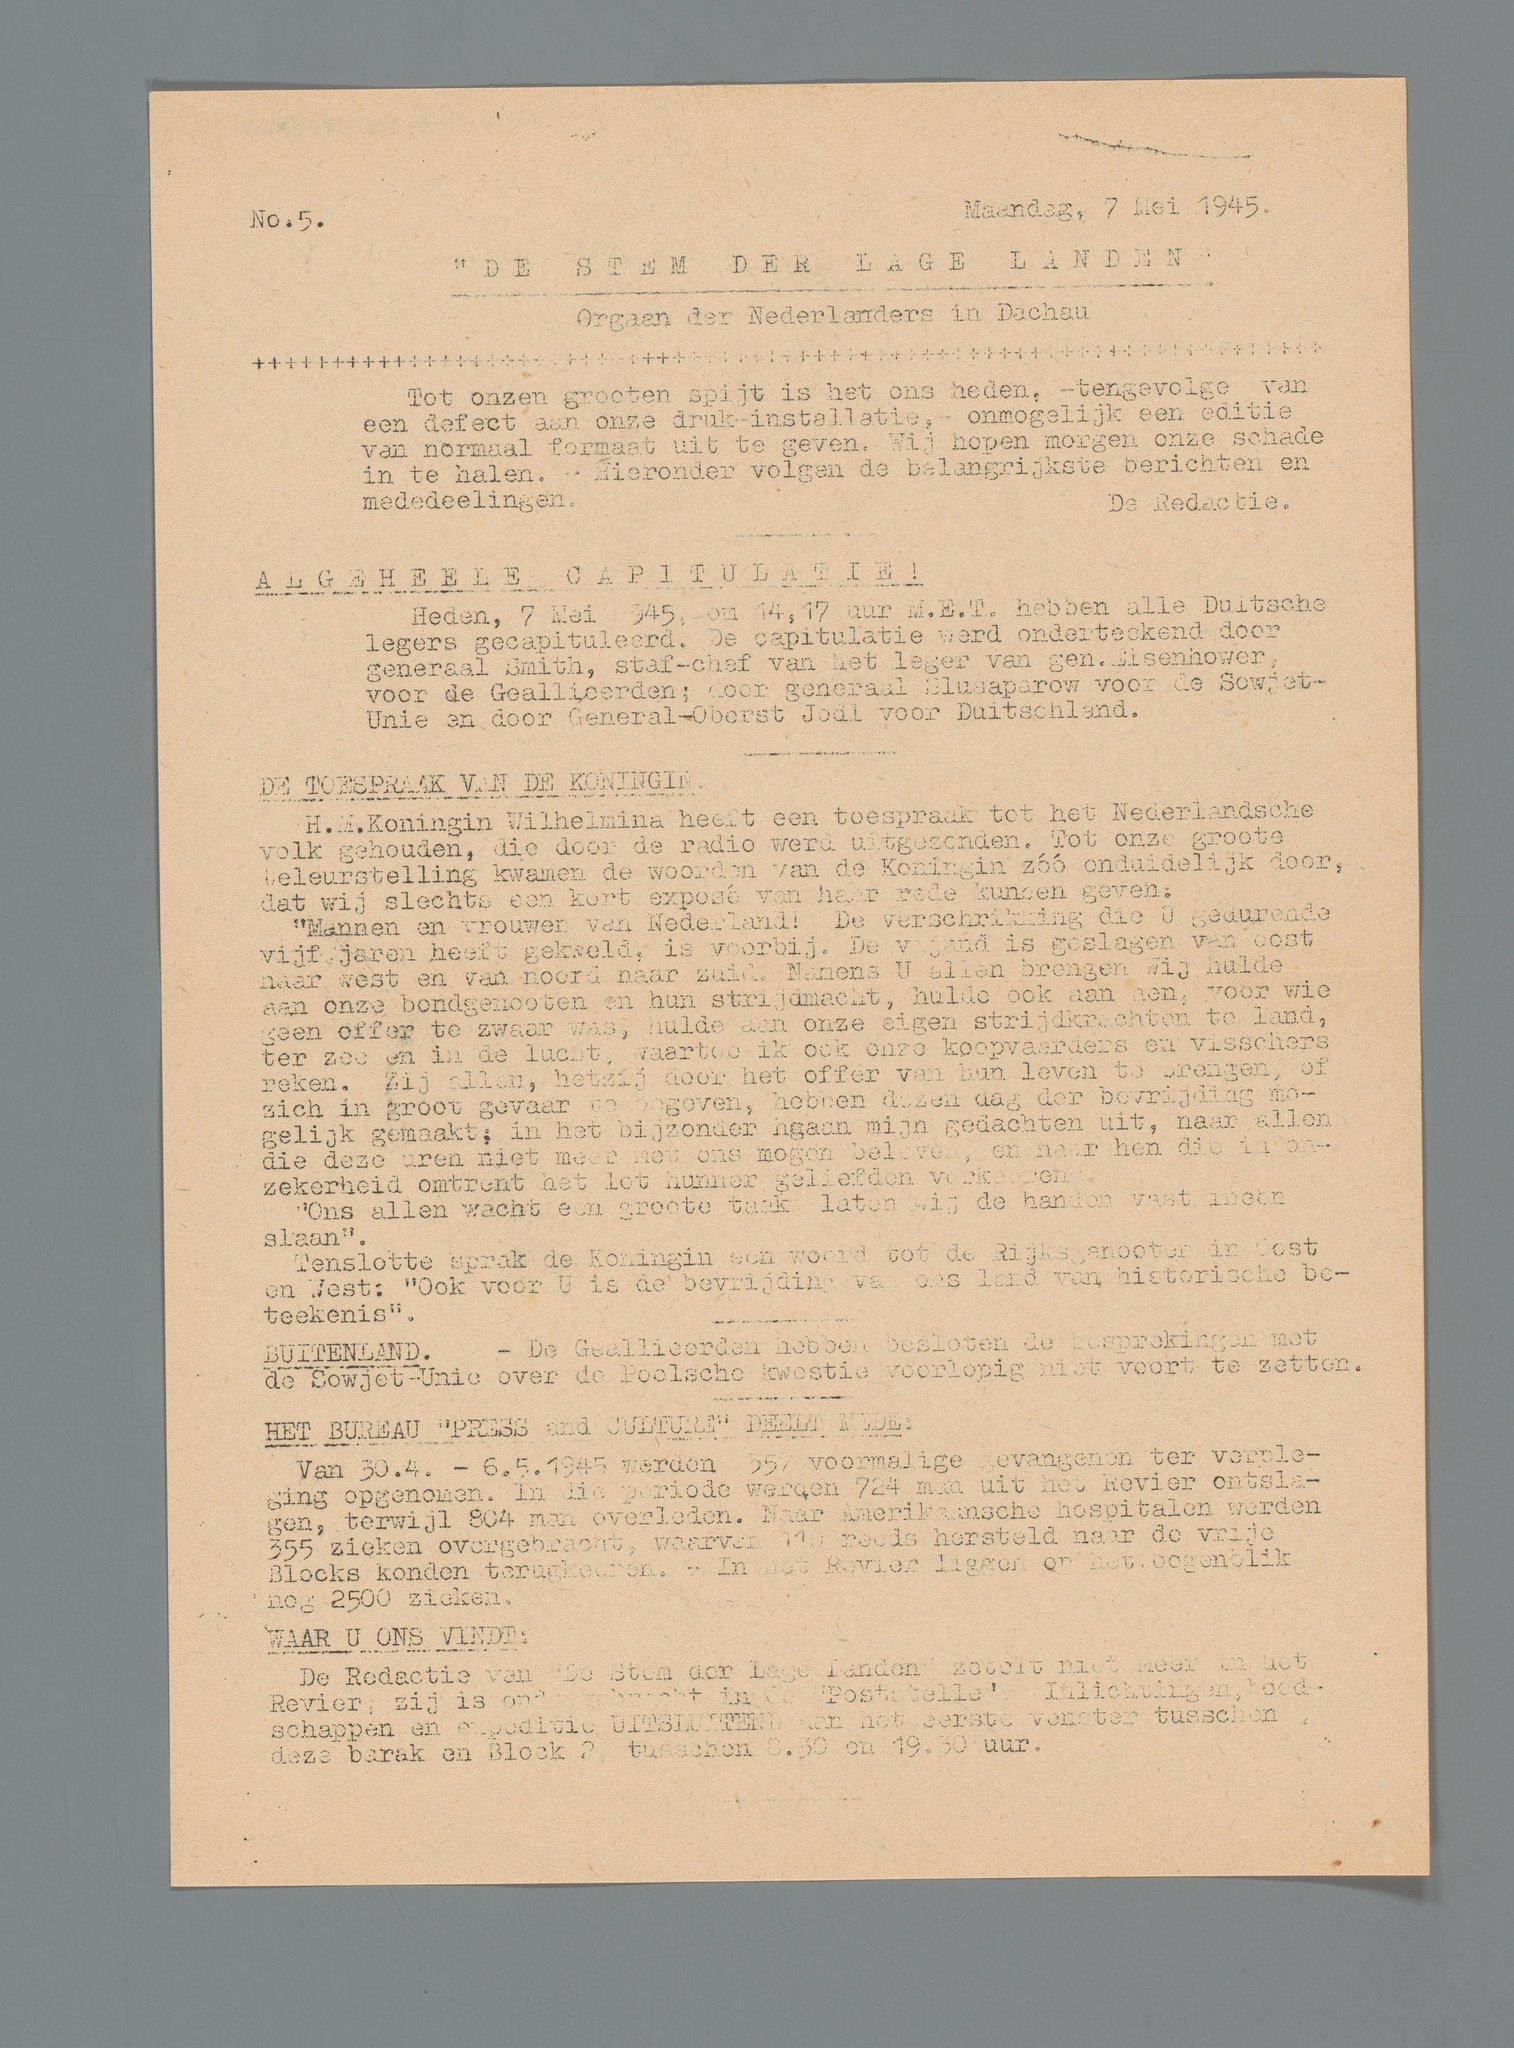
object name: pamphlet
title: De stem der lage landen, nr. 5, 7 mei 1945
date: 1945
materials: paper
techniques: mimeography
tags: etienne françois marie bouter, dachau, tweede wereldoorlog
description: Gestencilde krant 'De stem der lage landen / Orgaan der Nederlanders in Dachau', aflevering nr. 5, 7 mei 1945. Een blad bedrukt aan een zijde. Verschenen onder redactie van Ed Hoornik, Nico Rost en Marc van Hasselt.